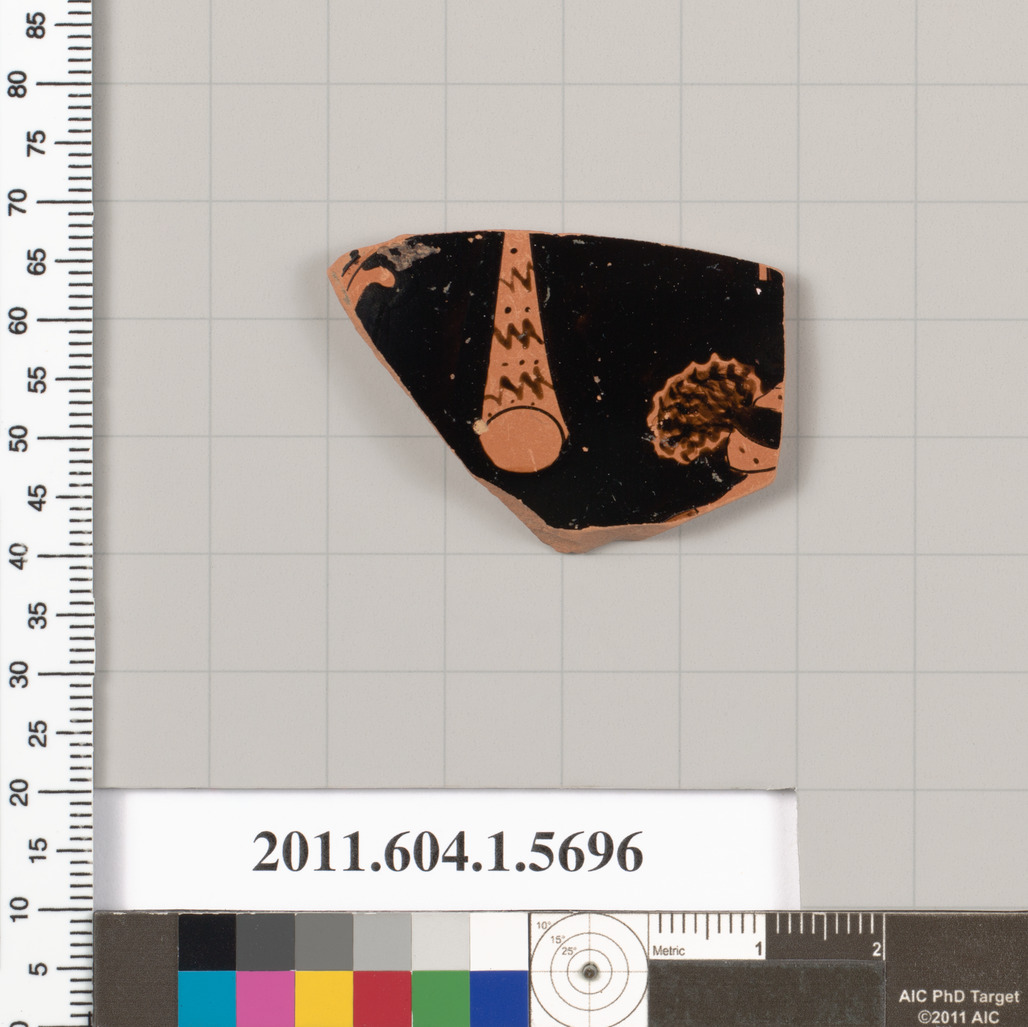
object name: kylix fragment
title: Terracotta fragment of a kylix (drinking cup)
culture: greek, attic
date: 490-470 BCE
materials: terracotta